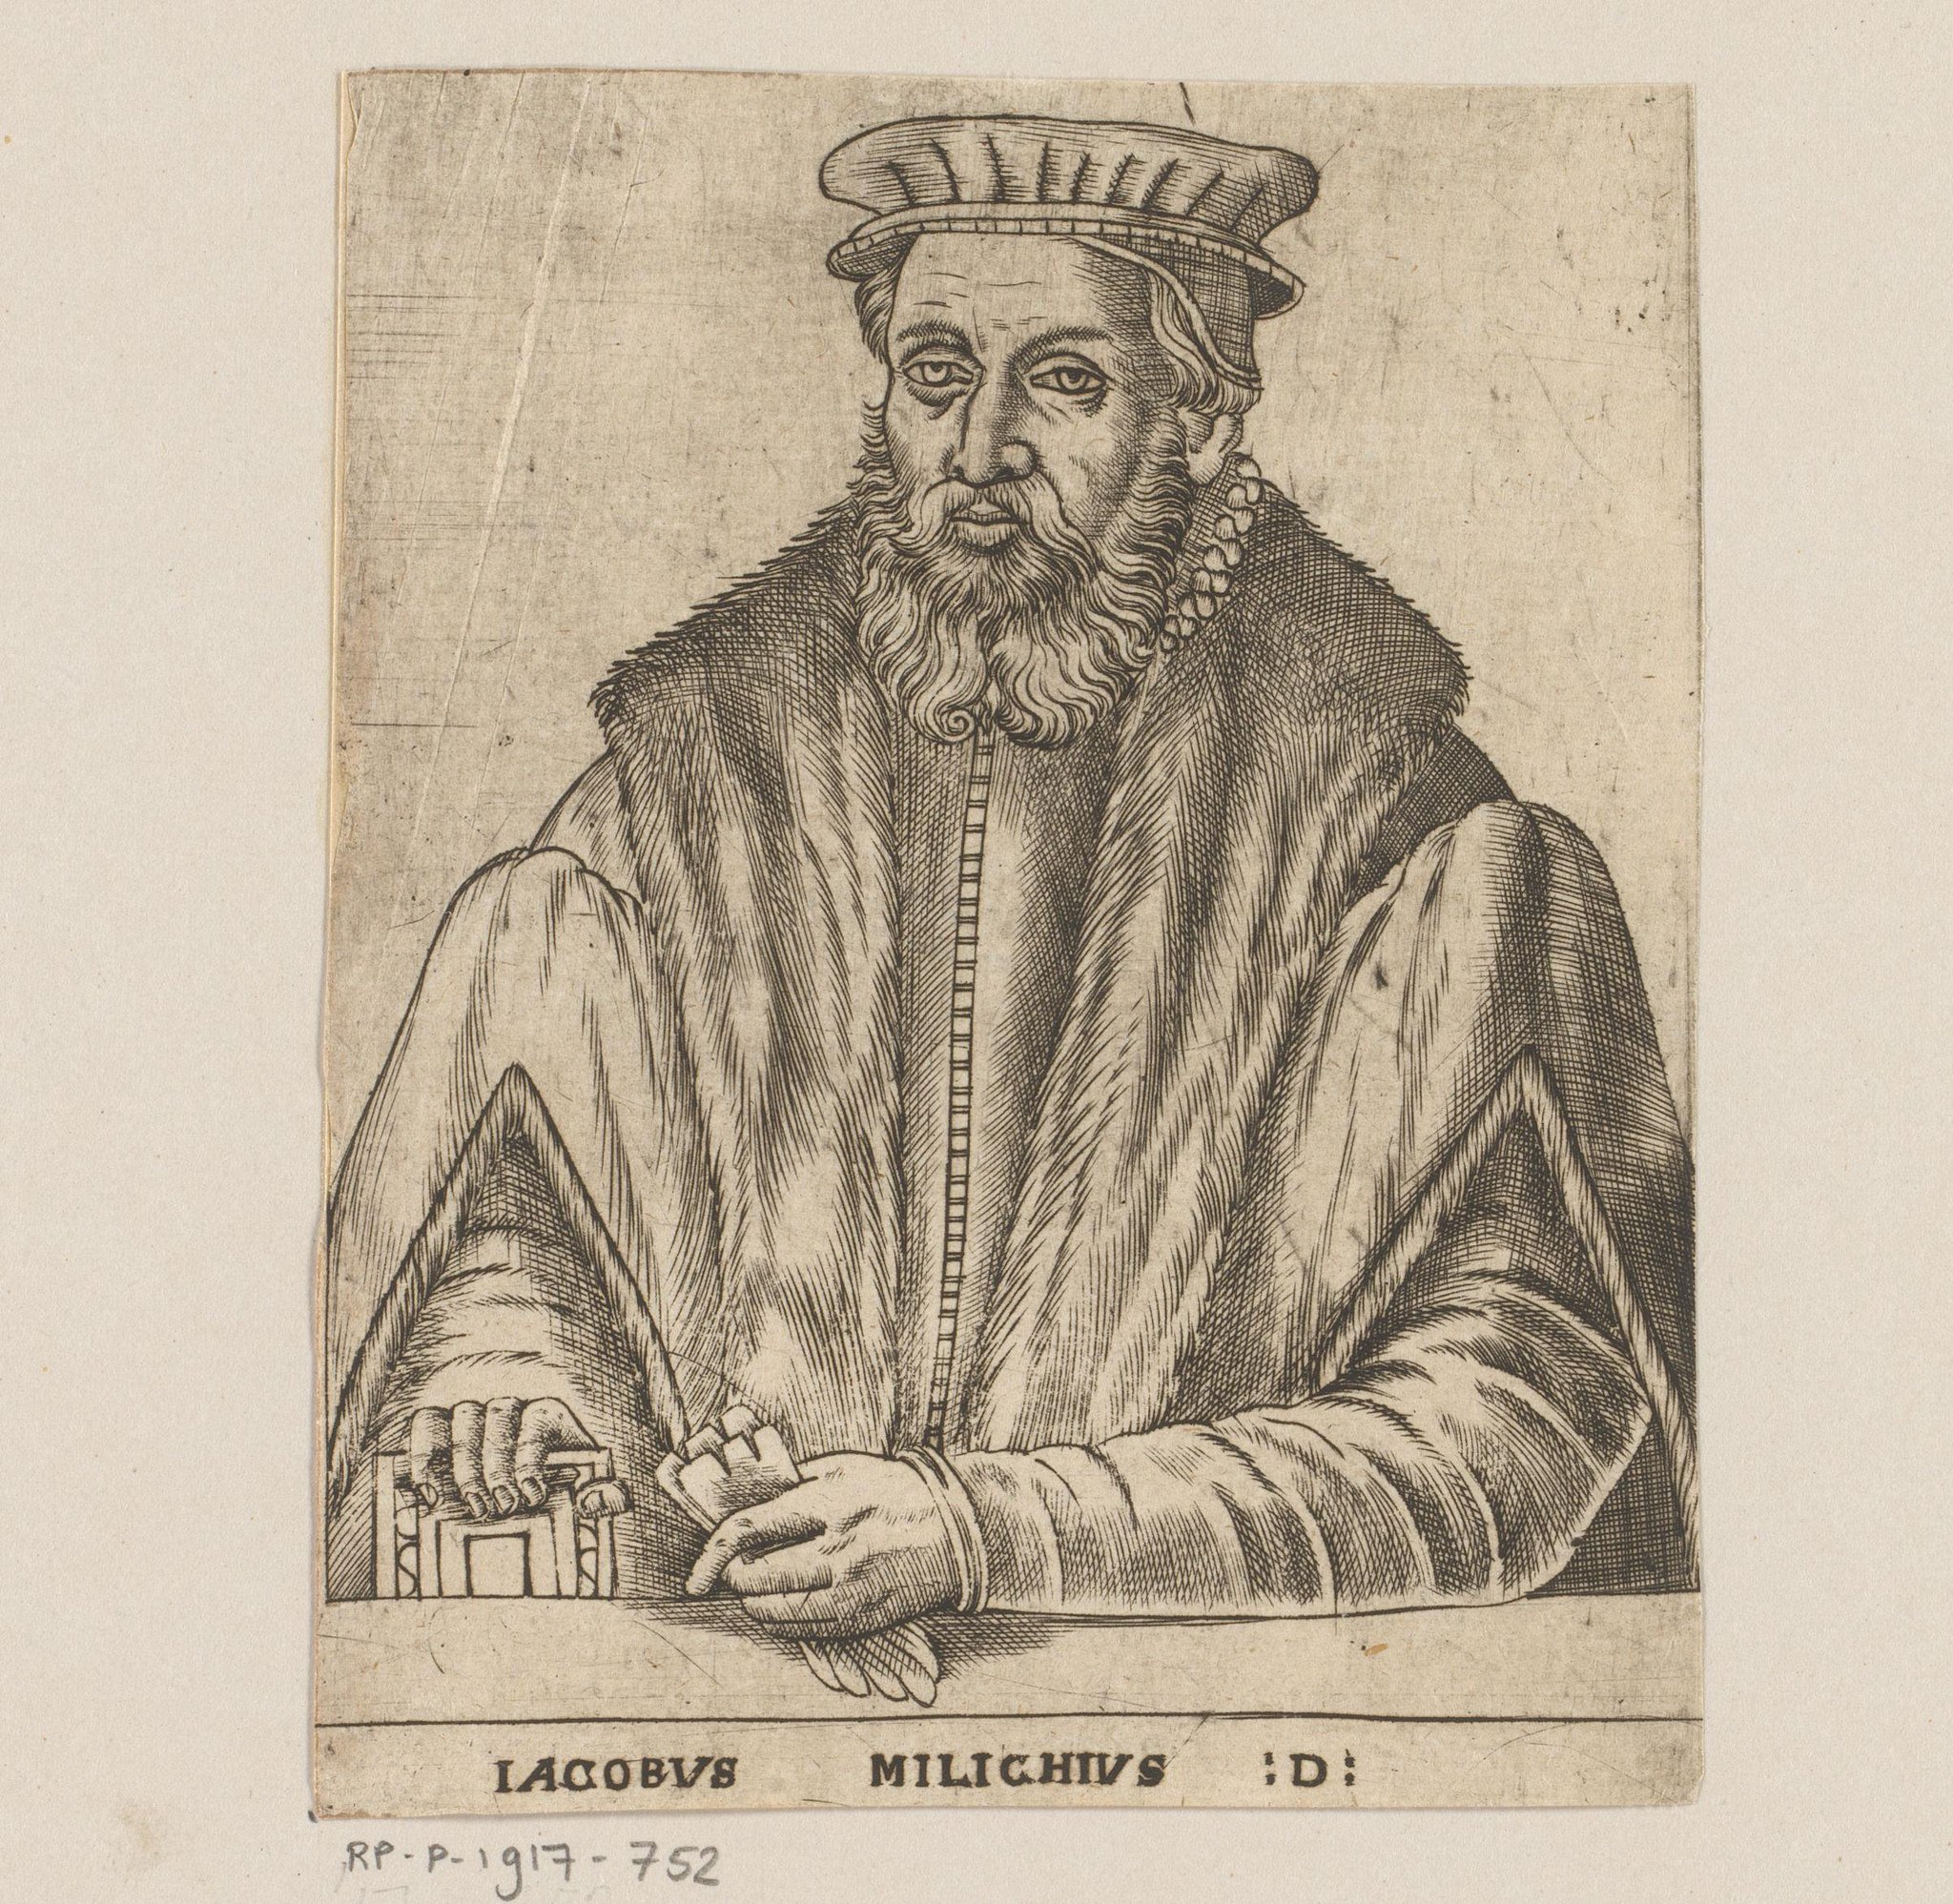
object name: print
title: Portret van Jacob Milich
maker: Anonymous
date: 1600-1649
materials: paper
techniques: engraving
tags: historical persons, physician, doctor, book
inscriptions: collector's mark: Lugt 2228